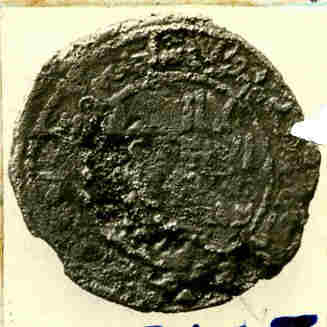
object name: coin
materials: copper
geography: iran